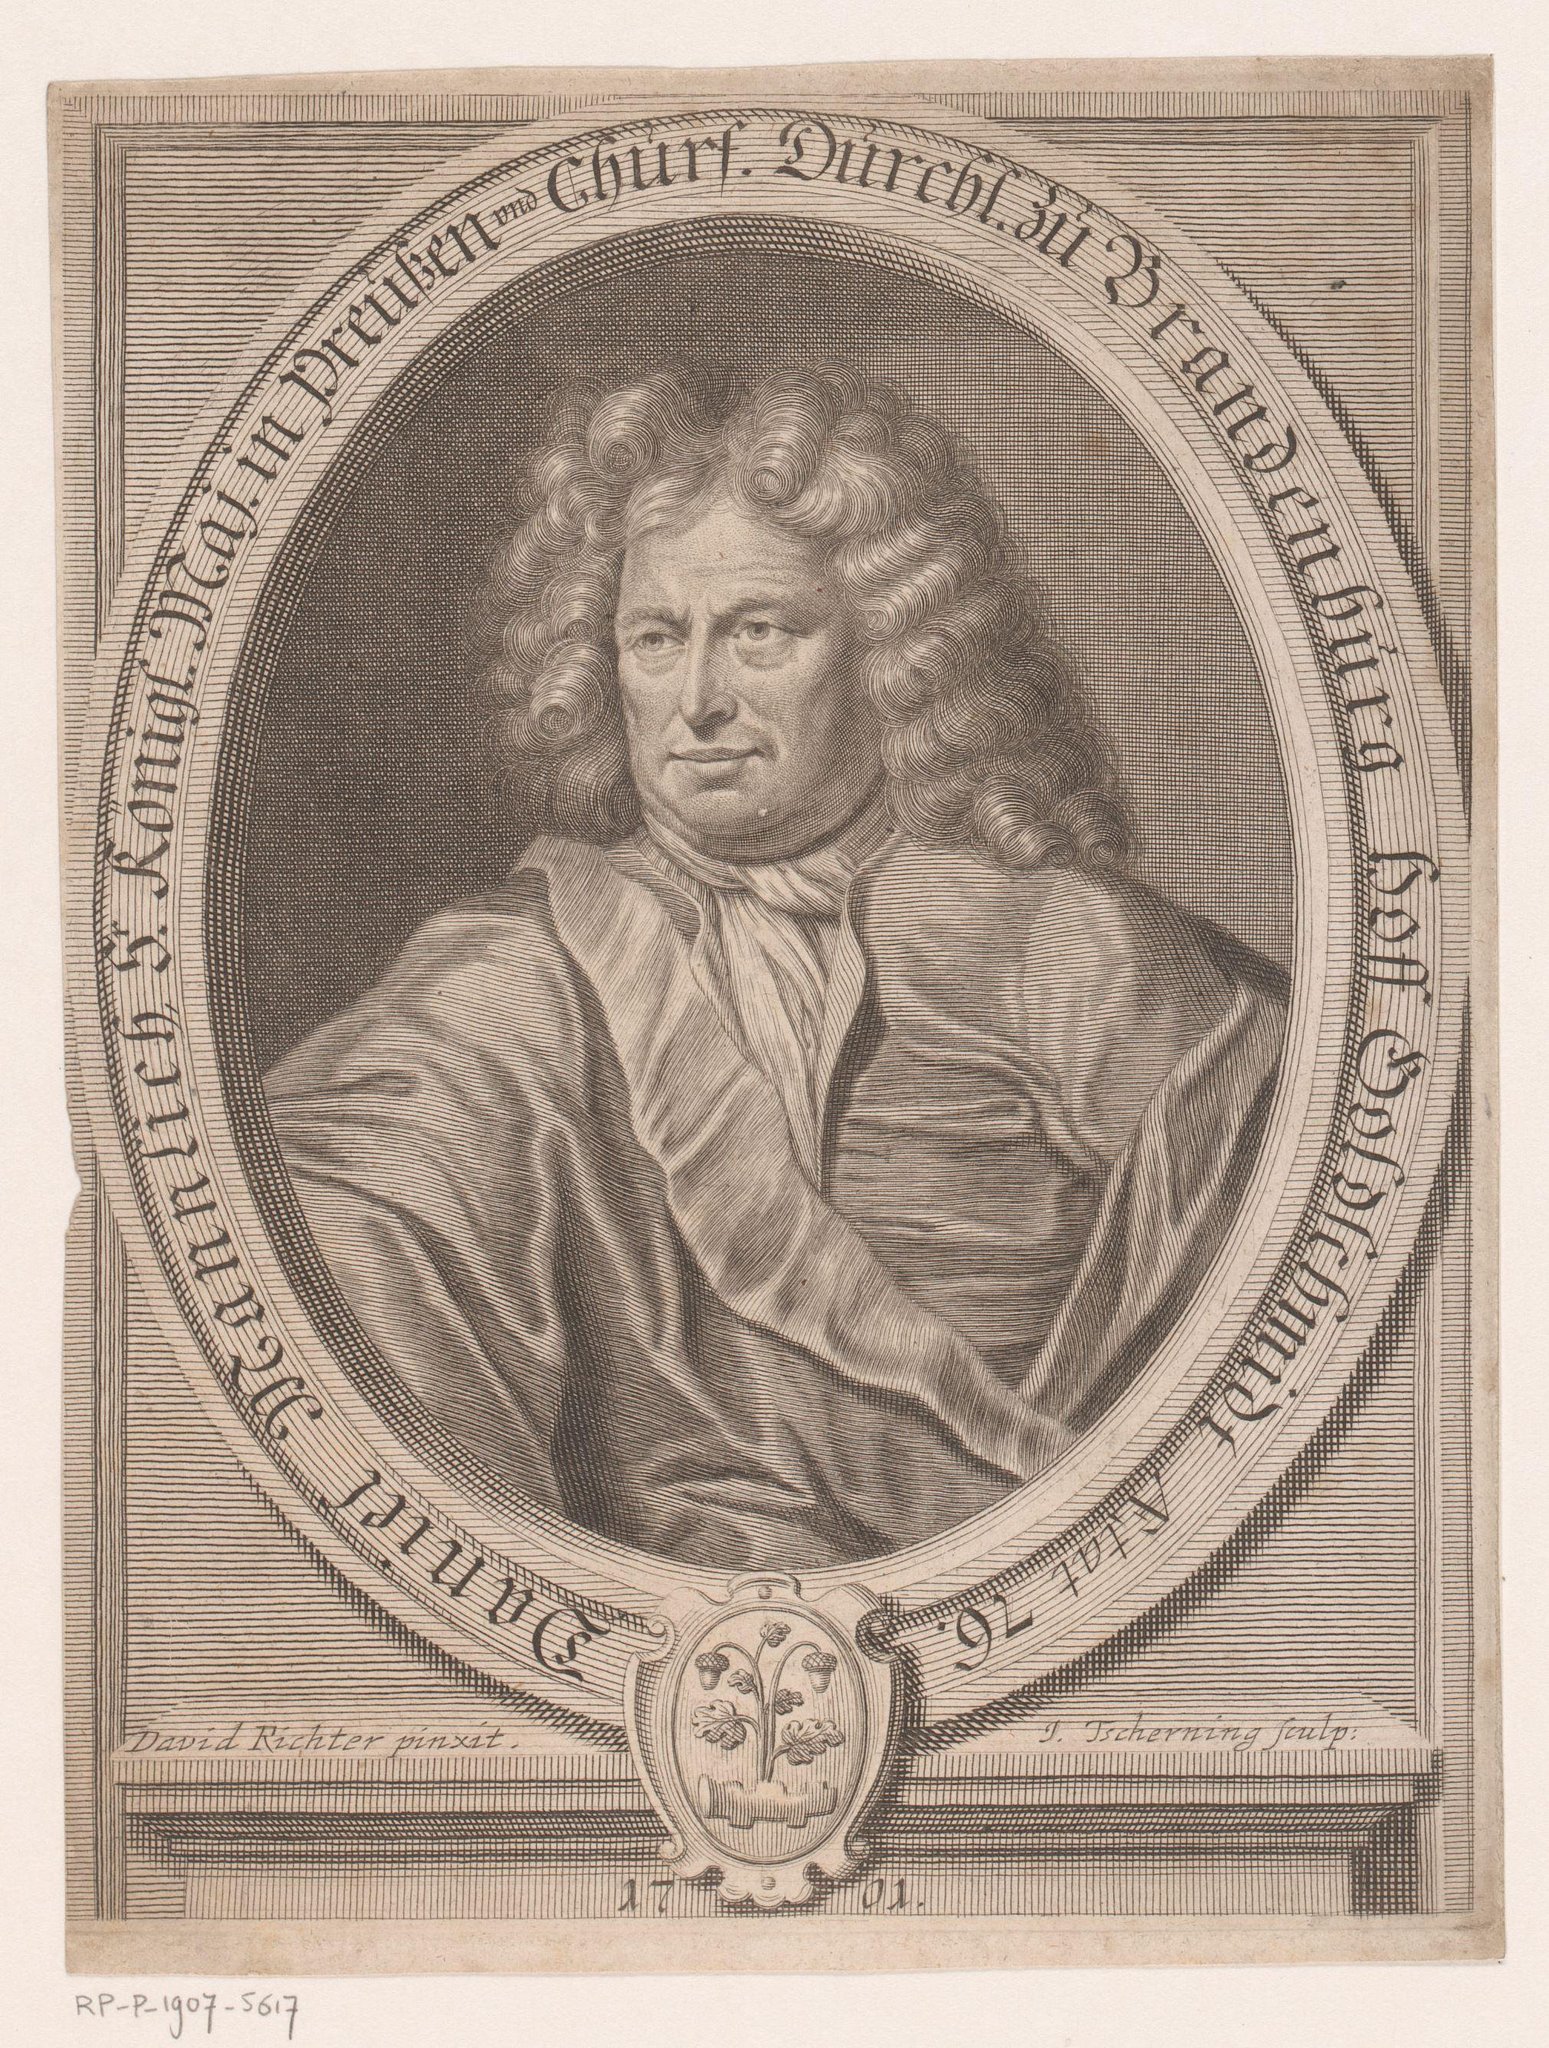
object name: print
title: Portret van Daniel Männlich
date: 1701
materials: paper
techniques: engraving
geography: germany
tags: berlin, goldsmith, historical persons, armorial bearing, heraldry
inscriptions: collector's mark: Lugt 2228